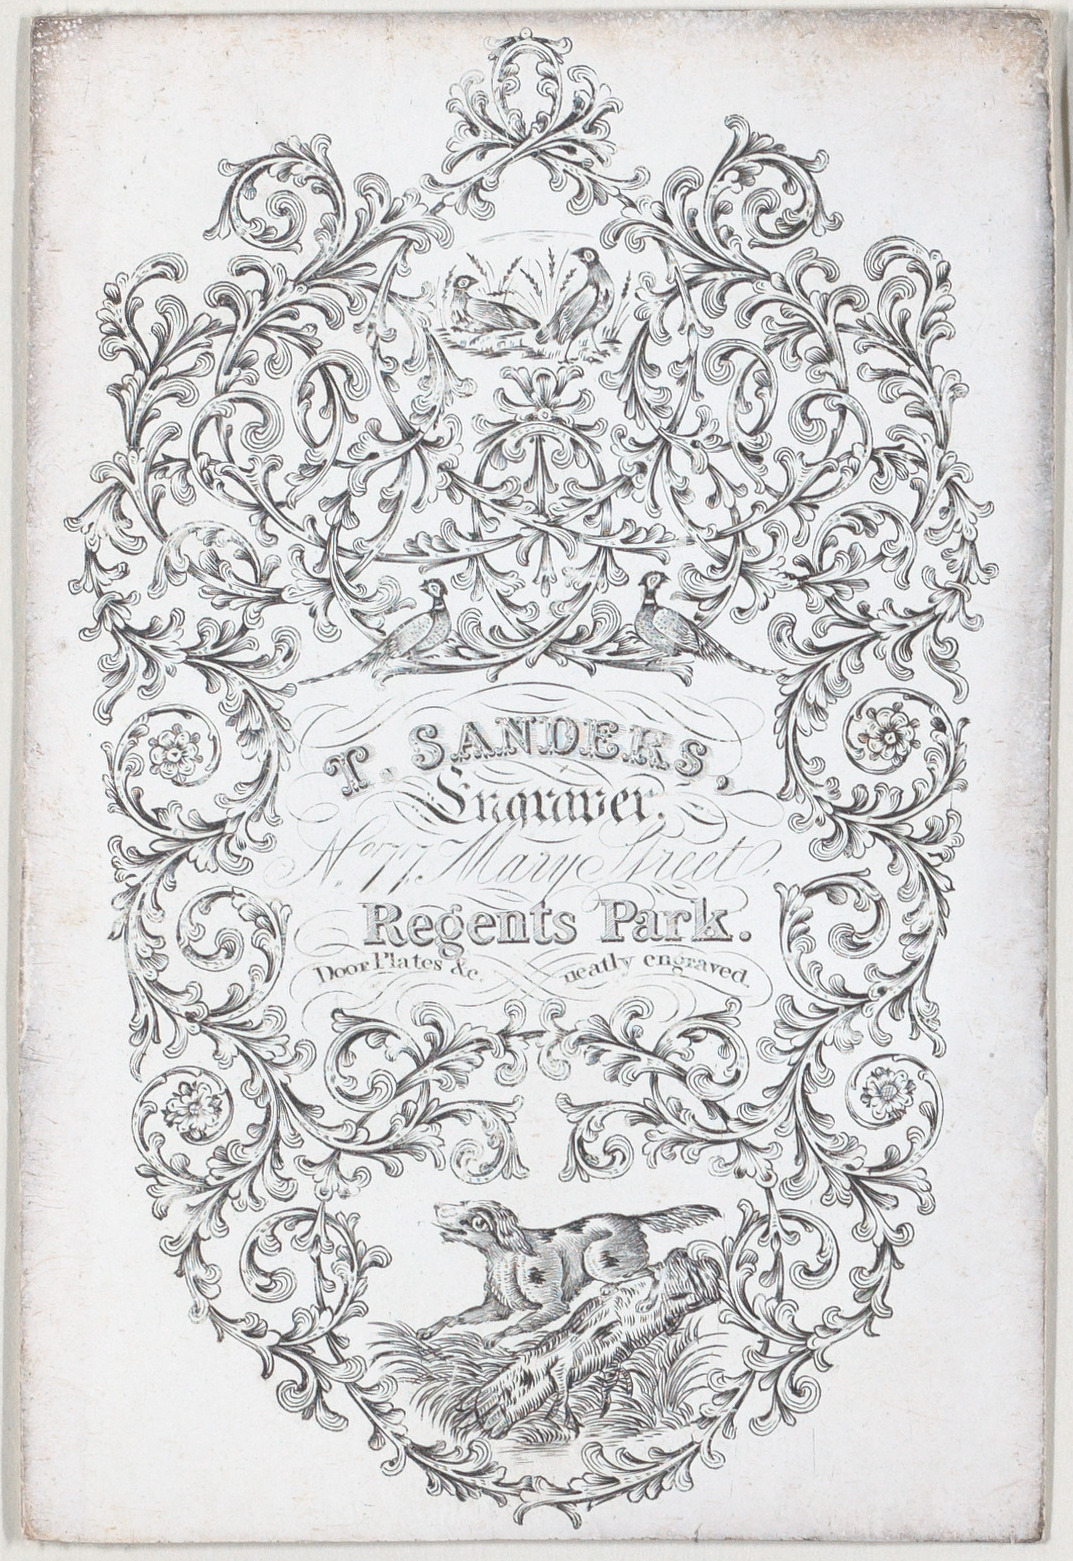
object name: print, trade card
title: Trade Card for T. Sanders, engraver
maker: anonymous, british, 19th century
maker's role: artist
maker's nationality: british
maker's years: 1800-1900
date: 1801-1900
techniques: engraving